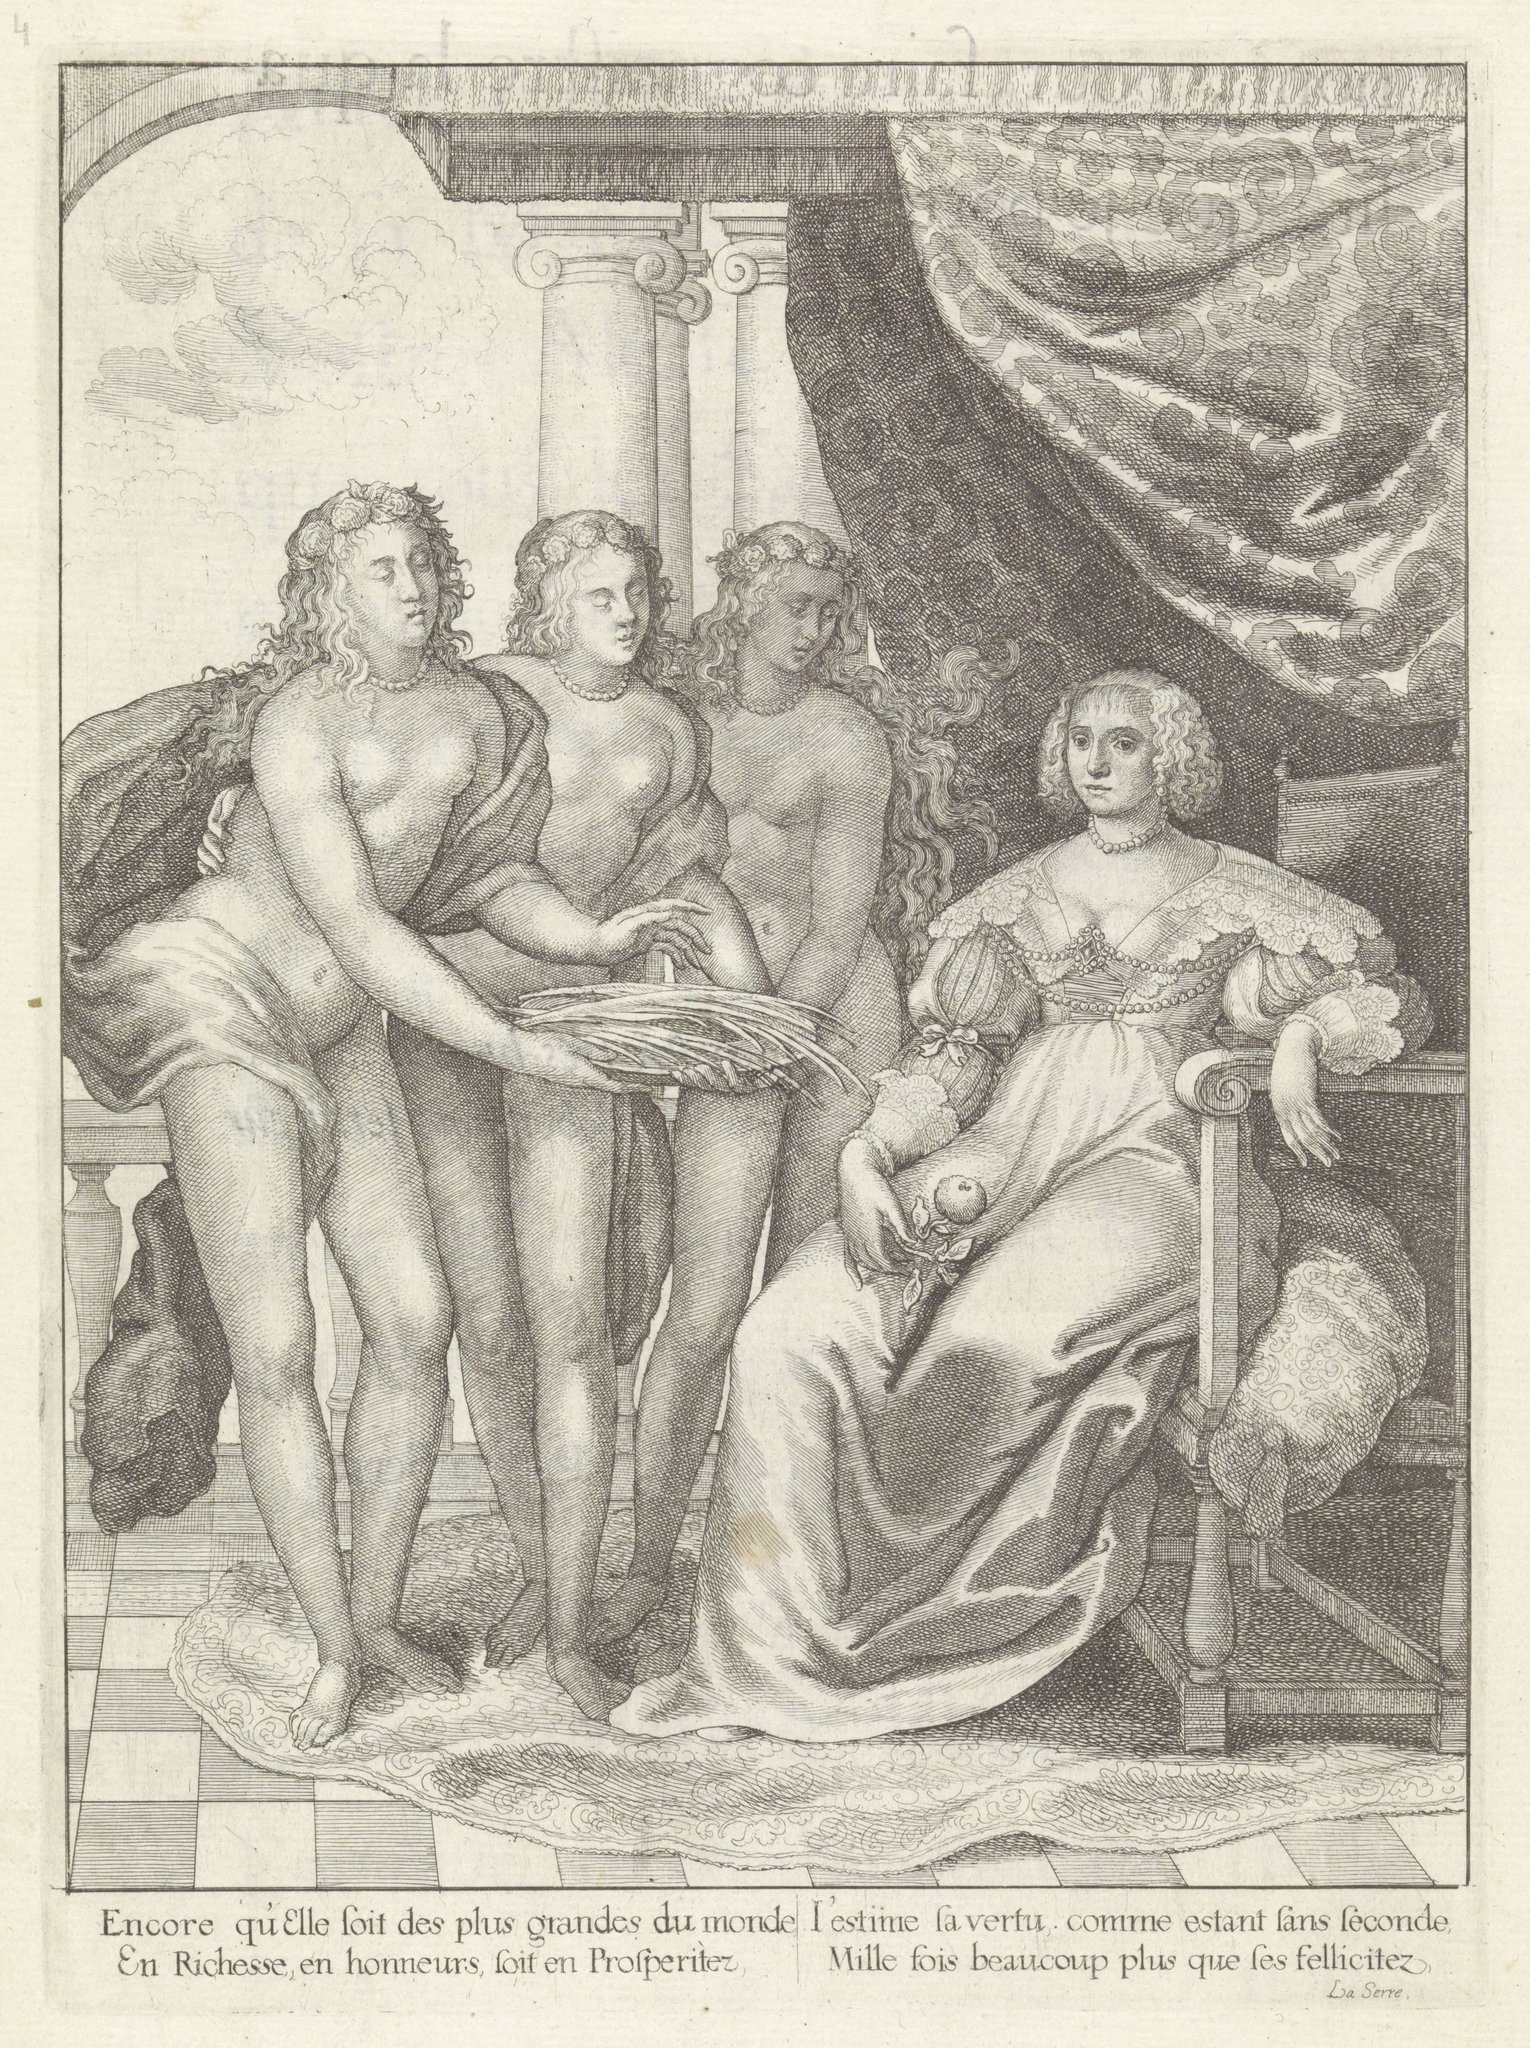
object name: print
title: Portret van Amalia van Solms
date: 1639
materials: paper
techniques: etching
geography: london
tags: amalia of solms-braunfels, graces (charites), generally three in number; 'gratie' (ripa)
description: Portret van Amalia. Ze zit in een vertrek met in haar rechterhand een oranjetak. De drie Gratiën bieden haar palmbladeren aan. In de ondermarge twee keer twee regels Franse tekst. De prent maakt deel uit van een boek over het bezoek van Maria de' Medici aan de Nederlanden.